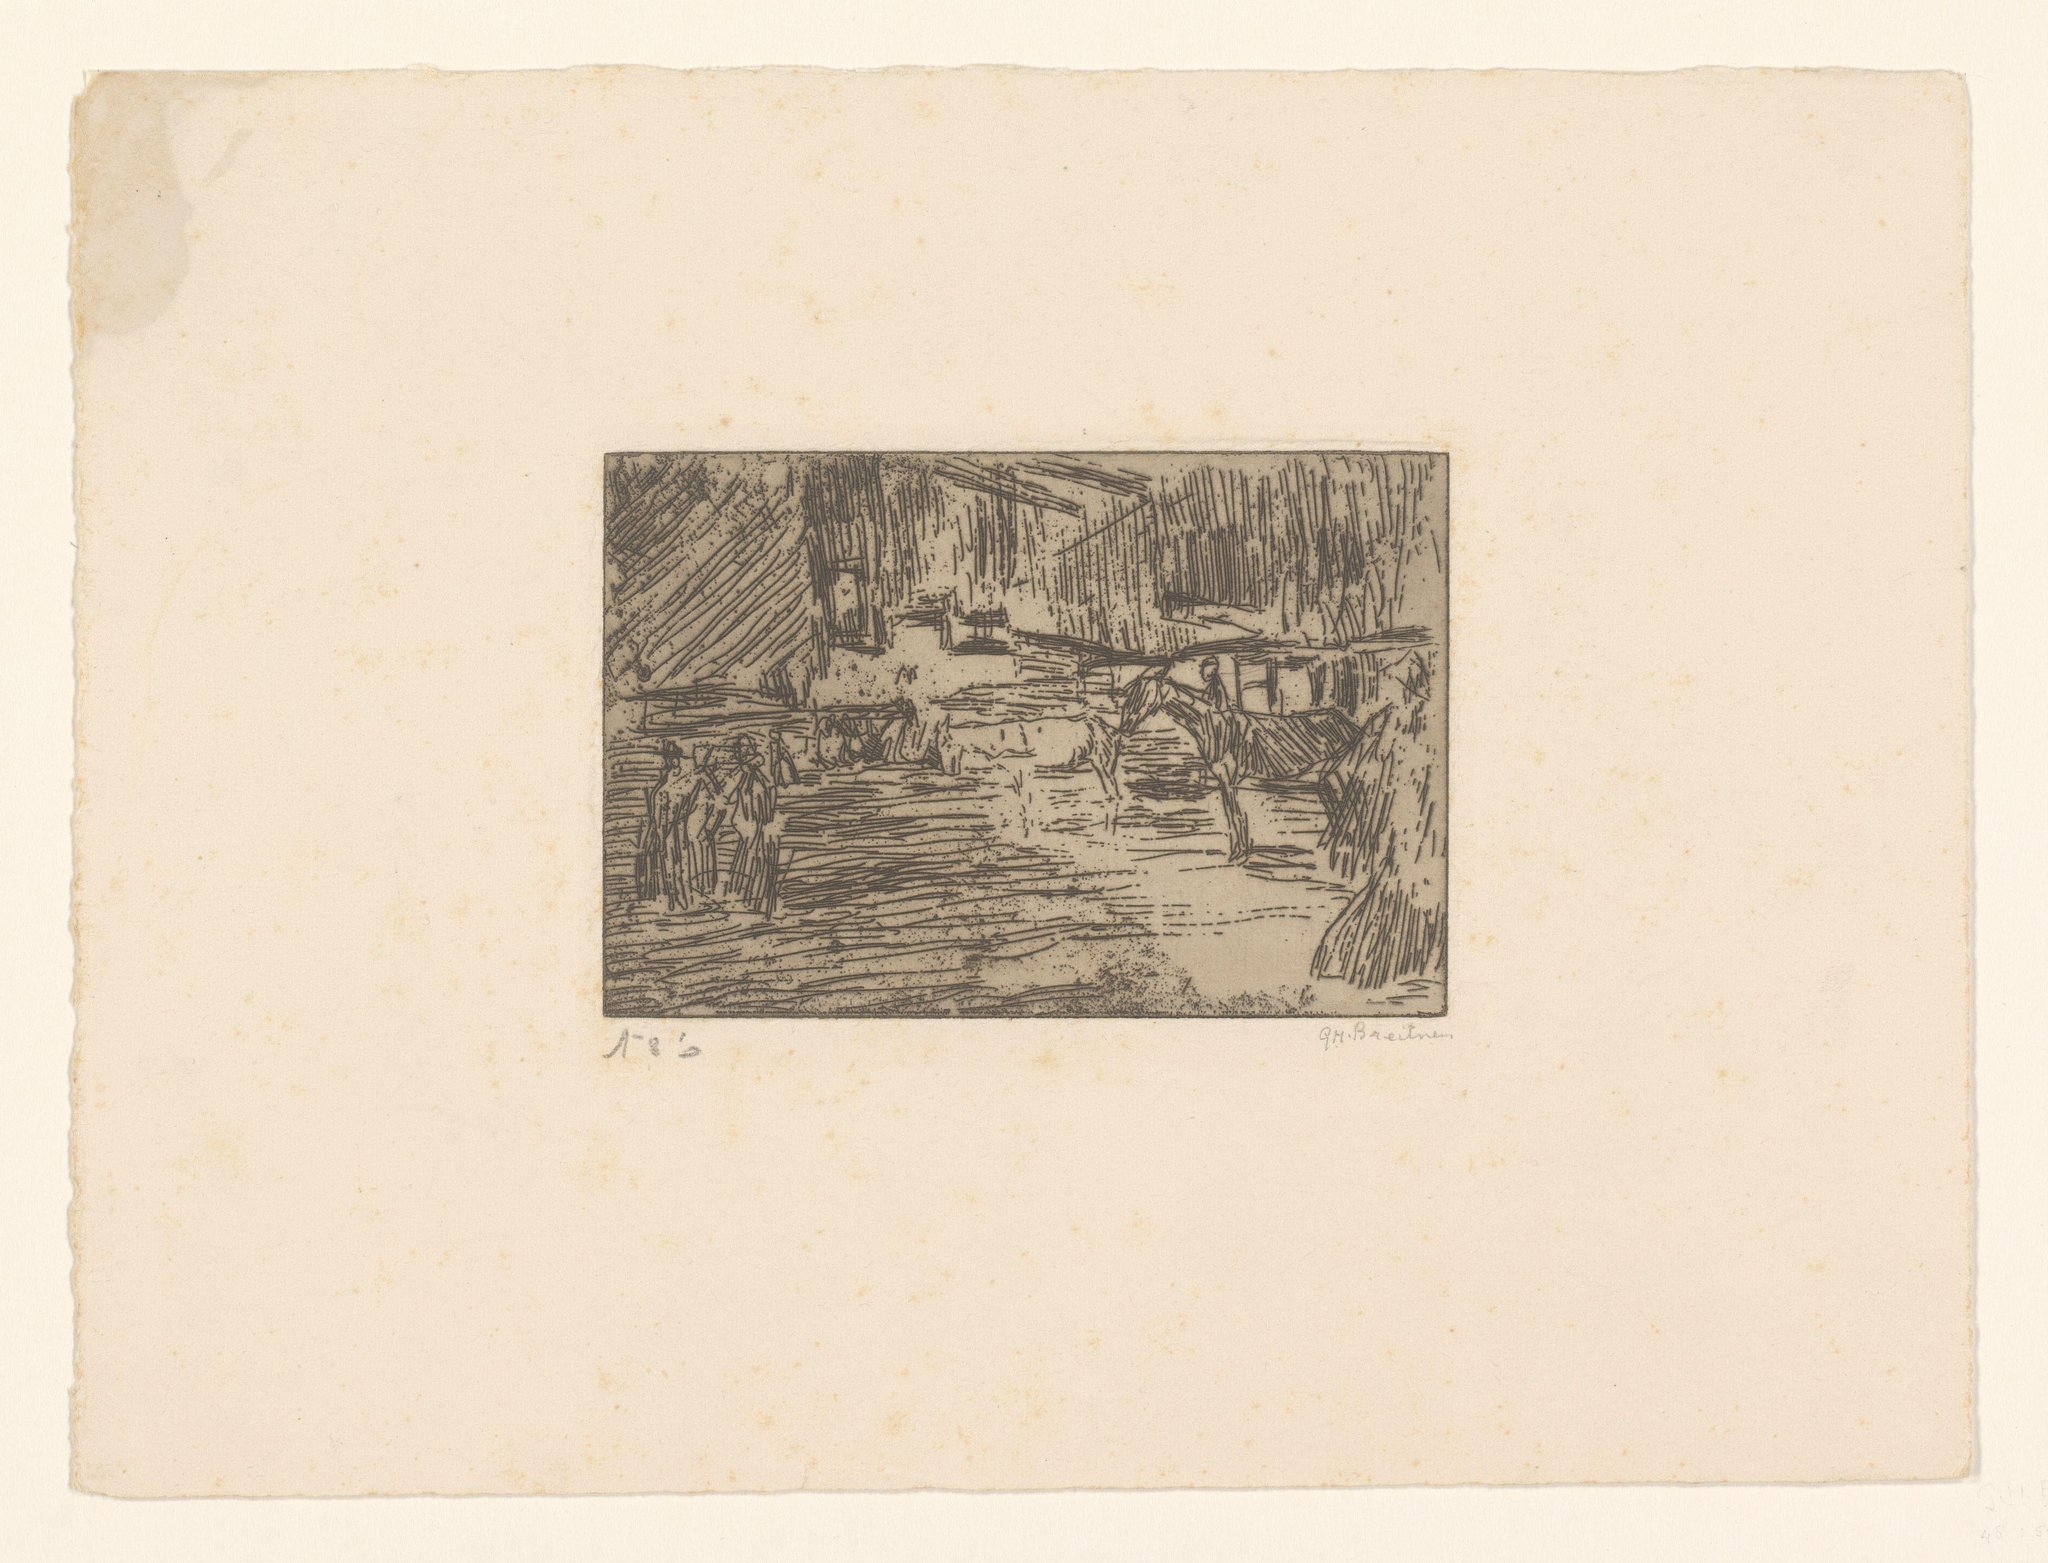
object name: print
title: Trampaarden (Leidseplein)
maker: george hendrik breitner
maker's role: draughtsman, painter, print maker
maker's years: 1857-1923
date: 1895-1900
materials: paper, ink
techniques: etching, intaglio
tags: diligence, omnibus, horse-tram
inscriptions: signature: ‘G.H. Breitner’, collector's mark: Lugt 2228, number: ‘No 6’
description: Rechts paarden en tramwagons, links enkele figuren; schetsmatig weergegeven.